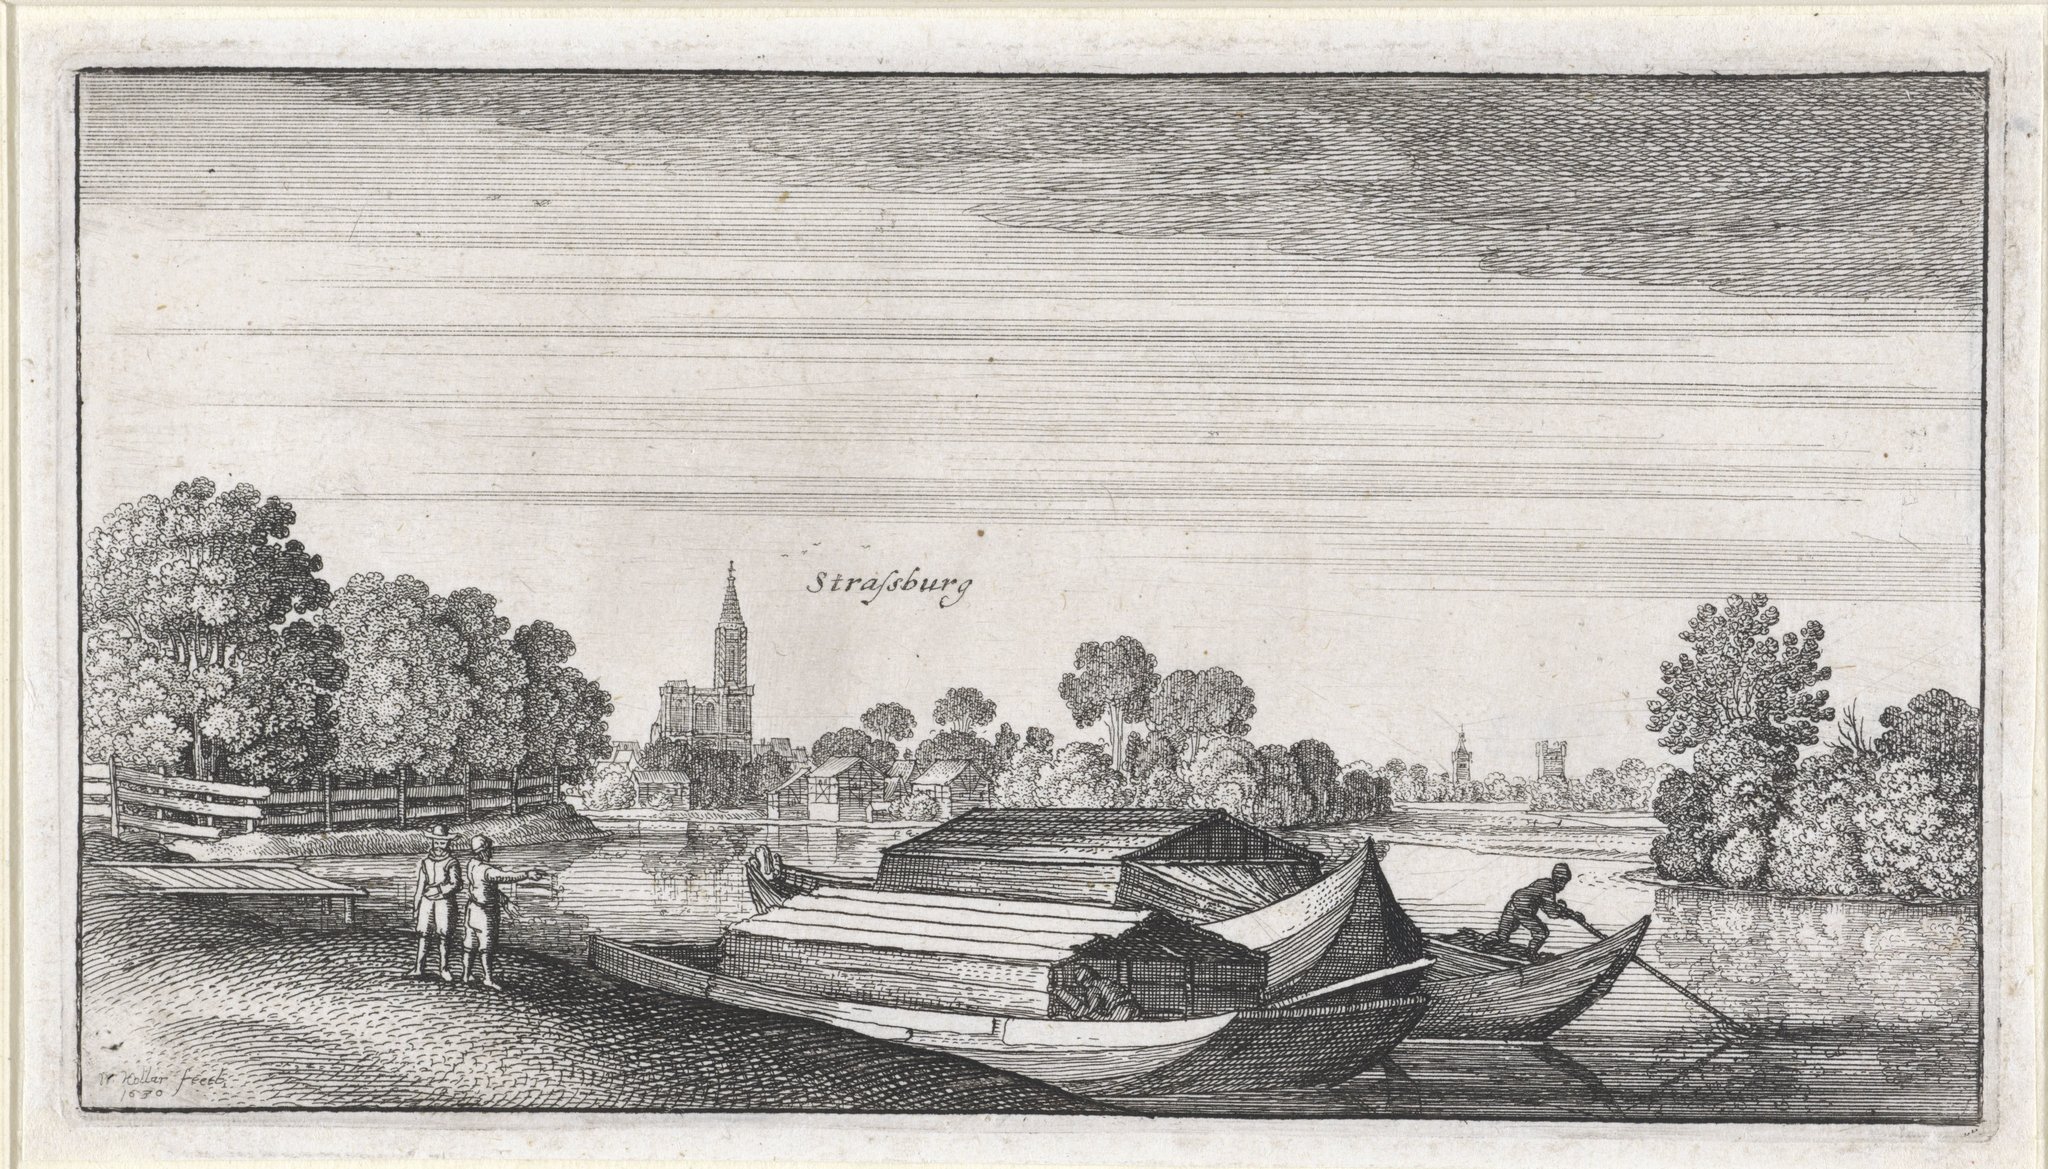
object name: print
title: Landschap met gezicht op Straatsburg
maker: wenceslaus hollar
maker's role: draughtsman, print maker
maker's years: 1607-1677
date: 1630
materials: paper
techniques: etching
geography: london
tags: city-view, and landscape with man-made constructions, river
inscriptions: collector's mark: Lugt 240